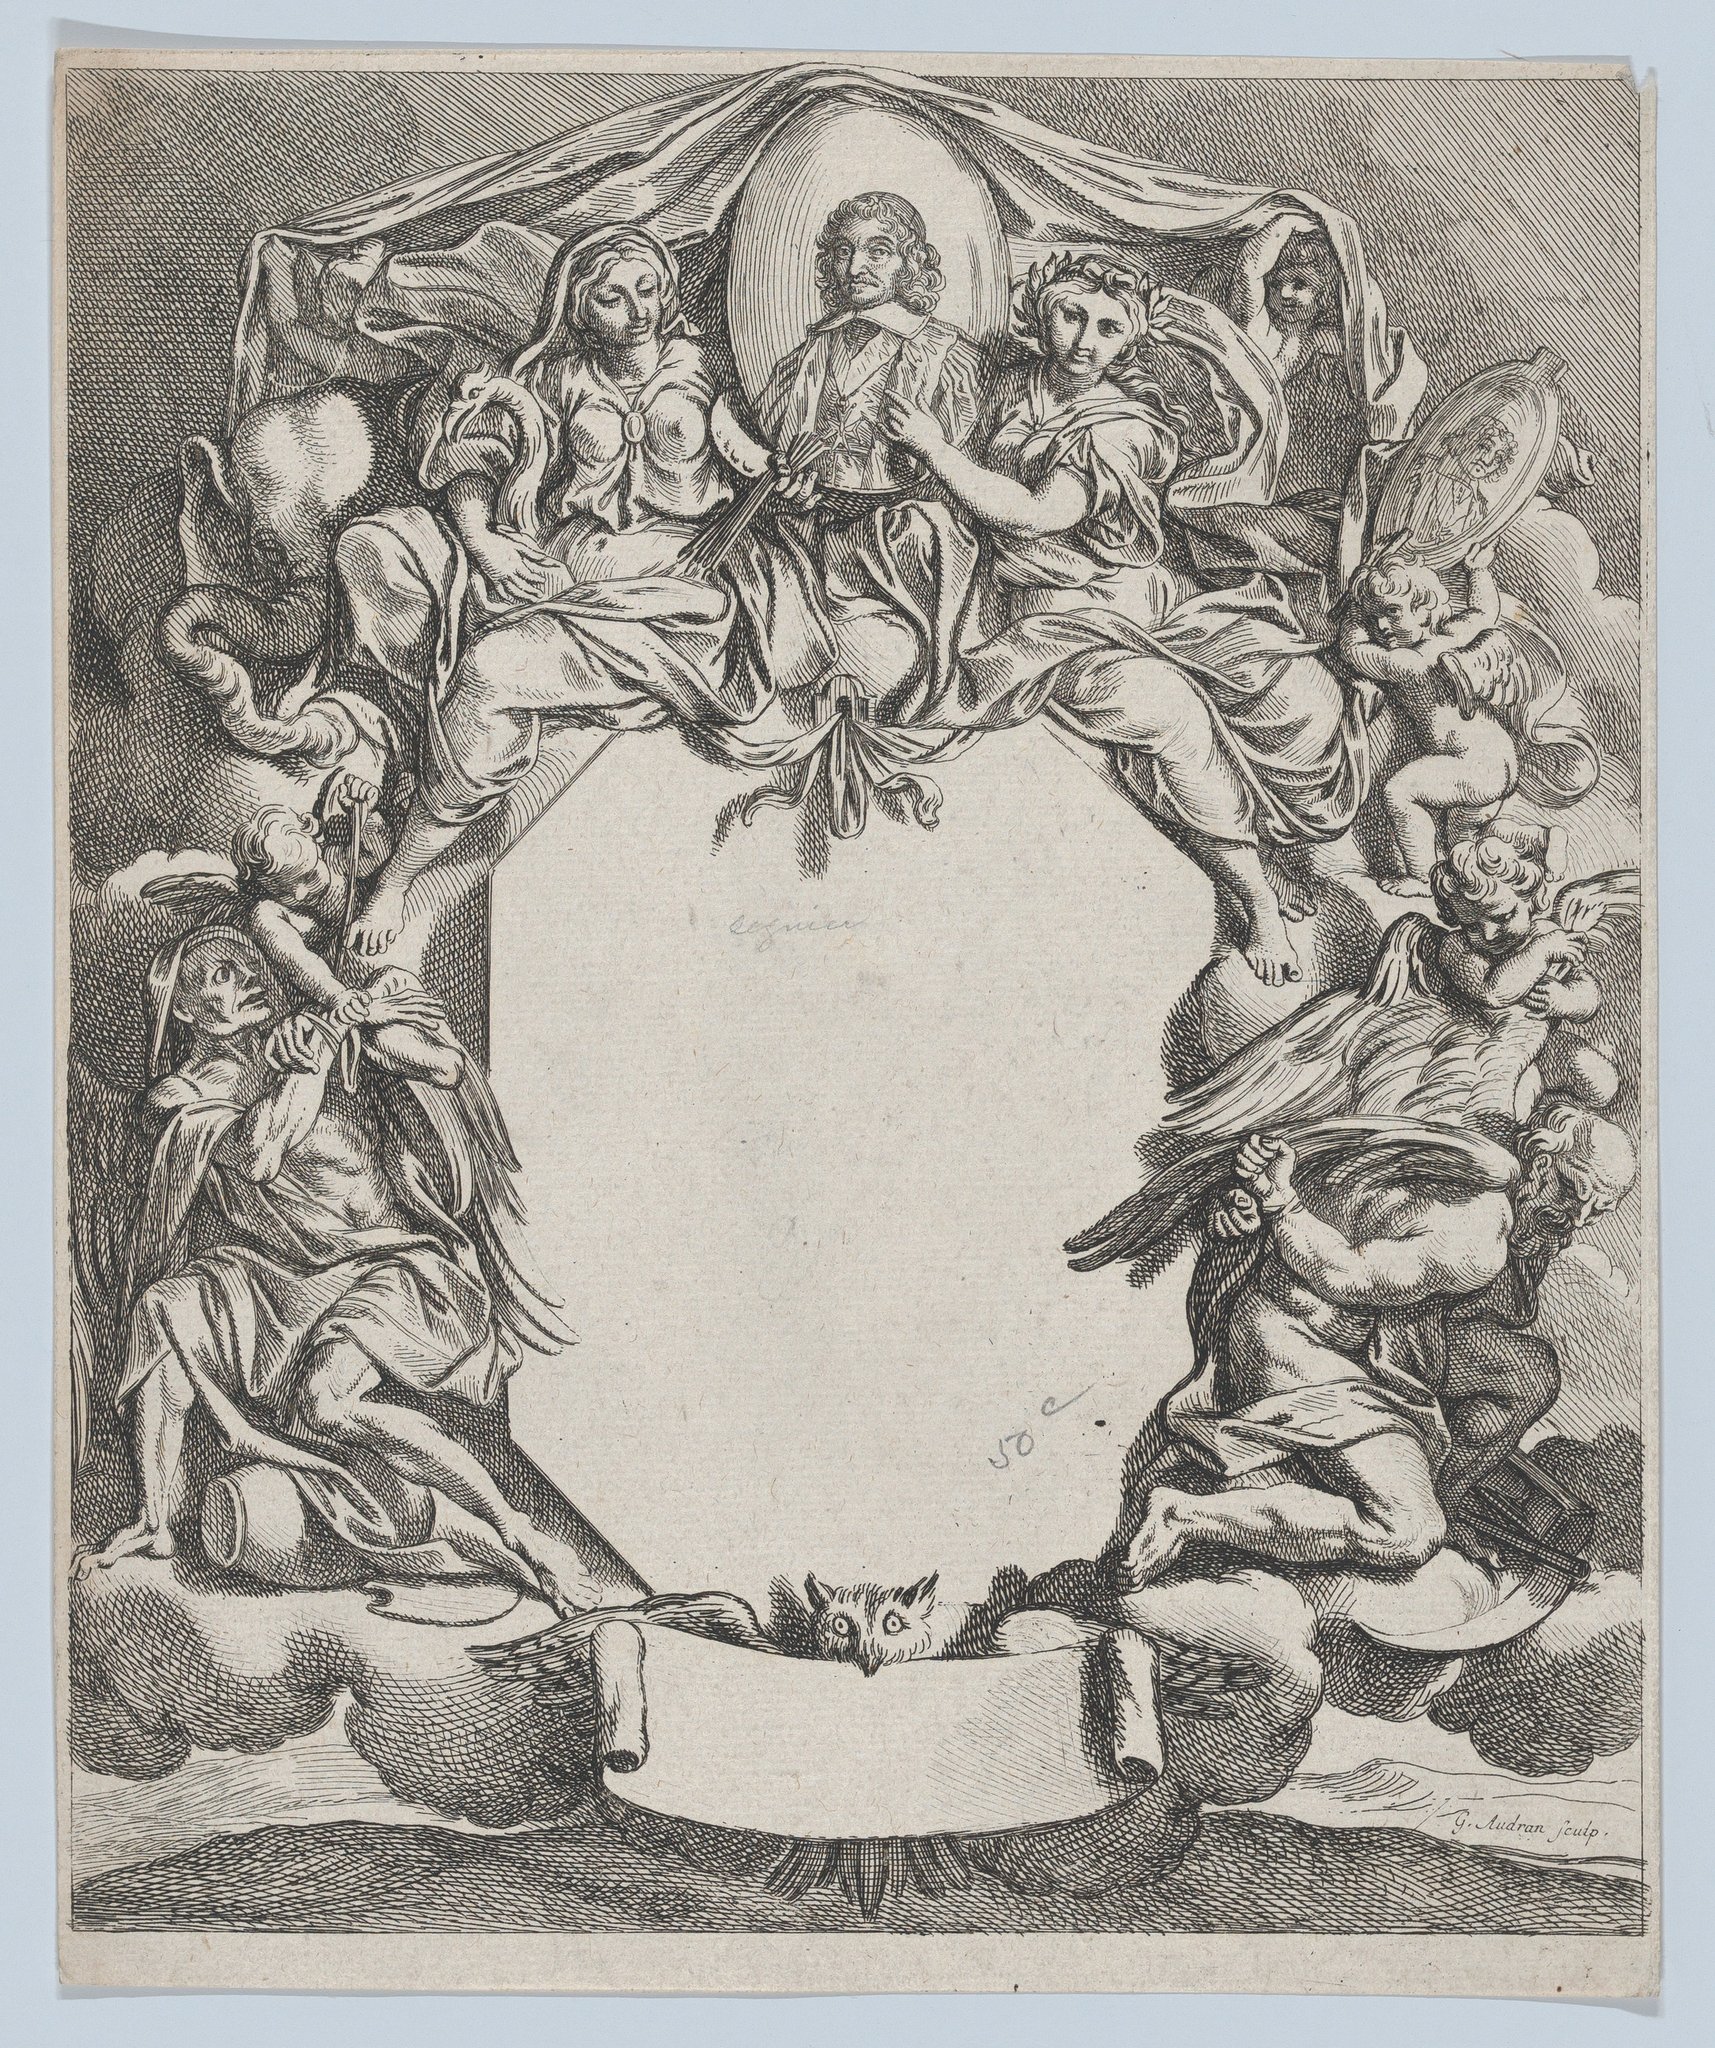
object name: print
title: Portrait of Pierre Séguier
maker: girard audran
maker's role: artist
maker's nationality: french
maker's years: 1640-1703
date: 1672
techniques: etching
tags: men,women